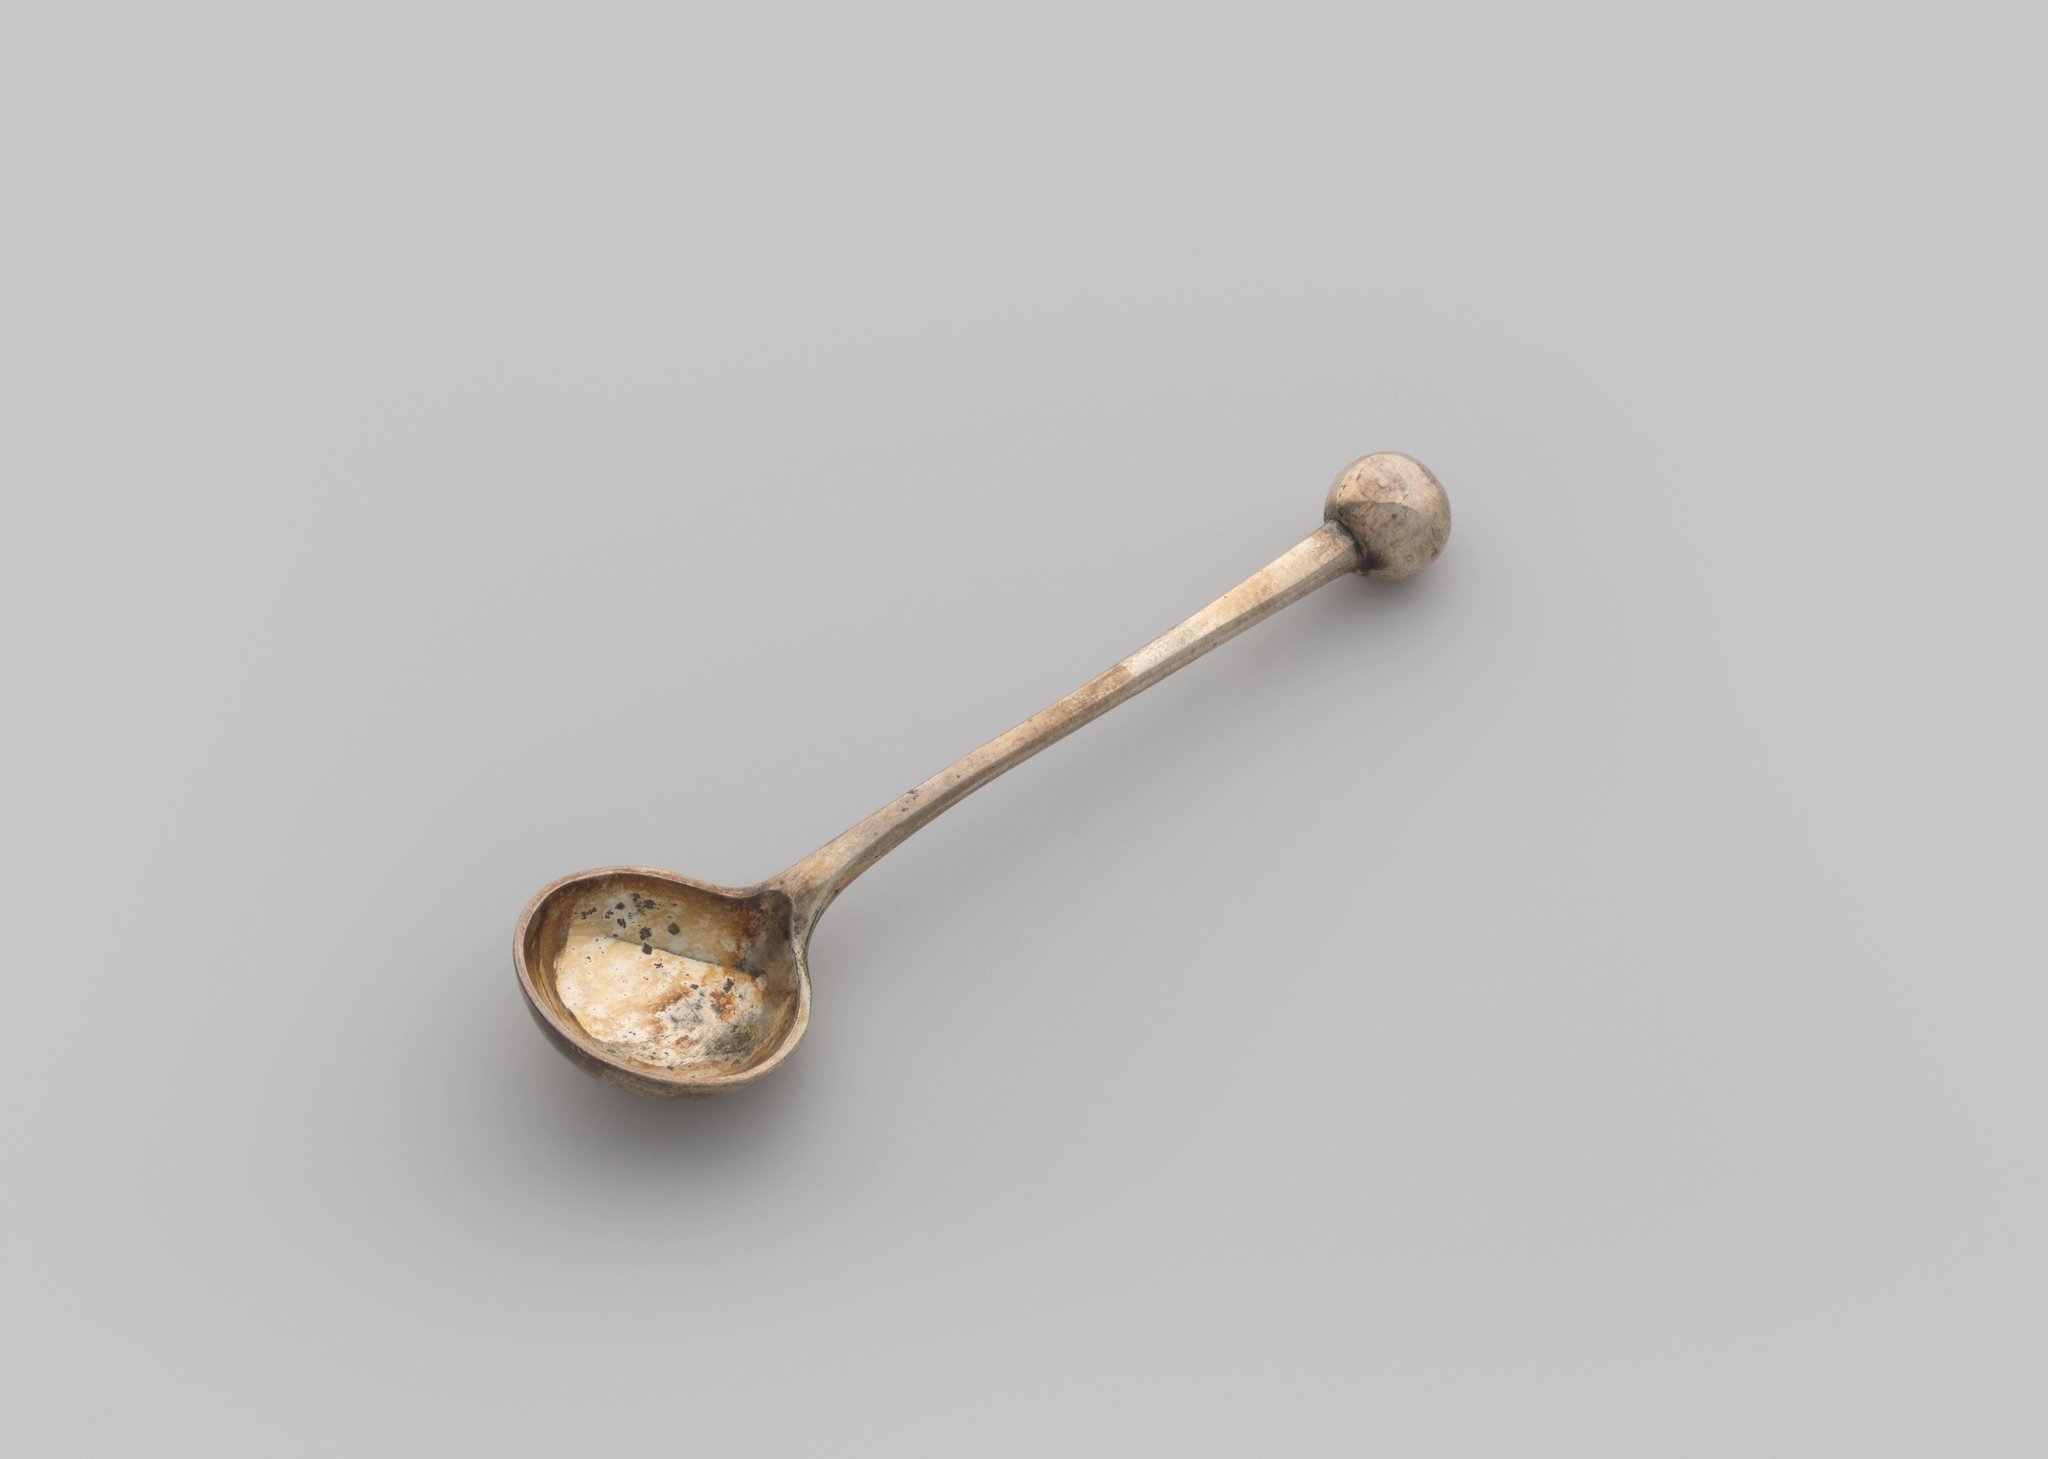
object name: spoon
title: Zoutlepel met ronde bak en ronde steel met bolbekroning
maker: Anonymous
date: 1800-1900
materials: silver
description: Zoutlepel van zilver met een ronde bak en ronde steel met bolbekroning.